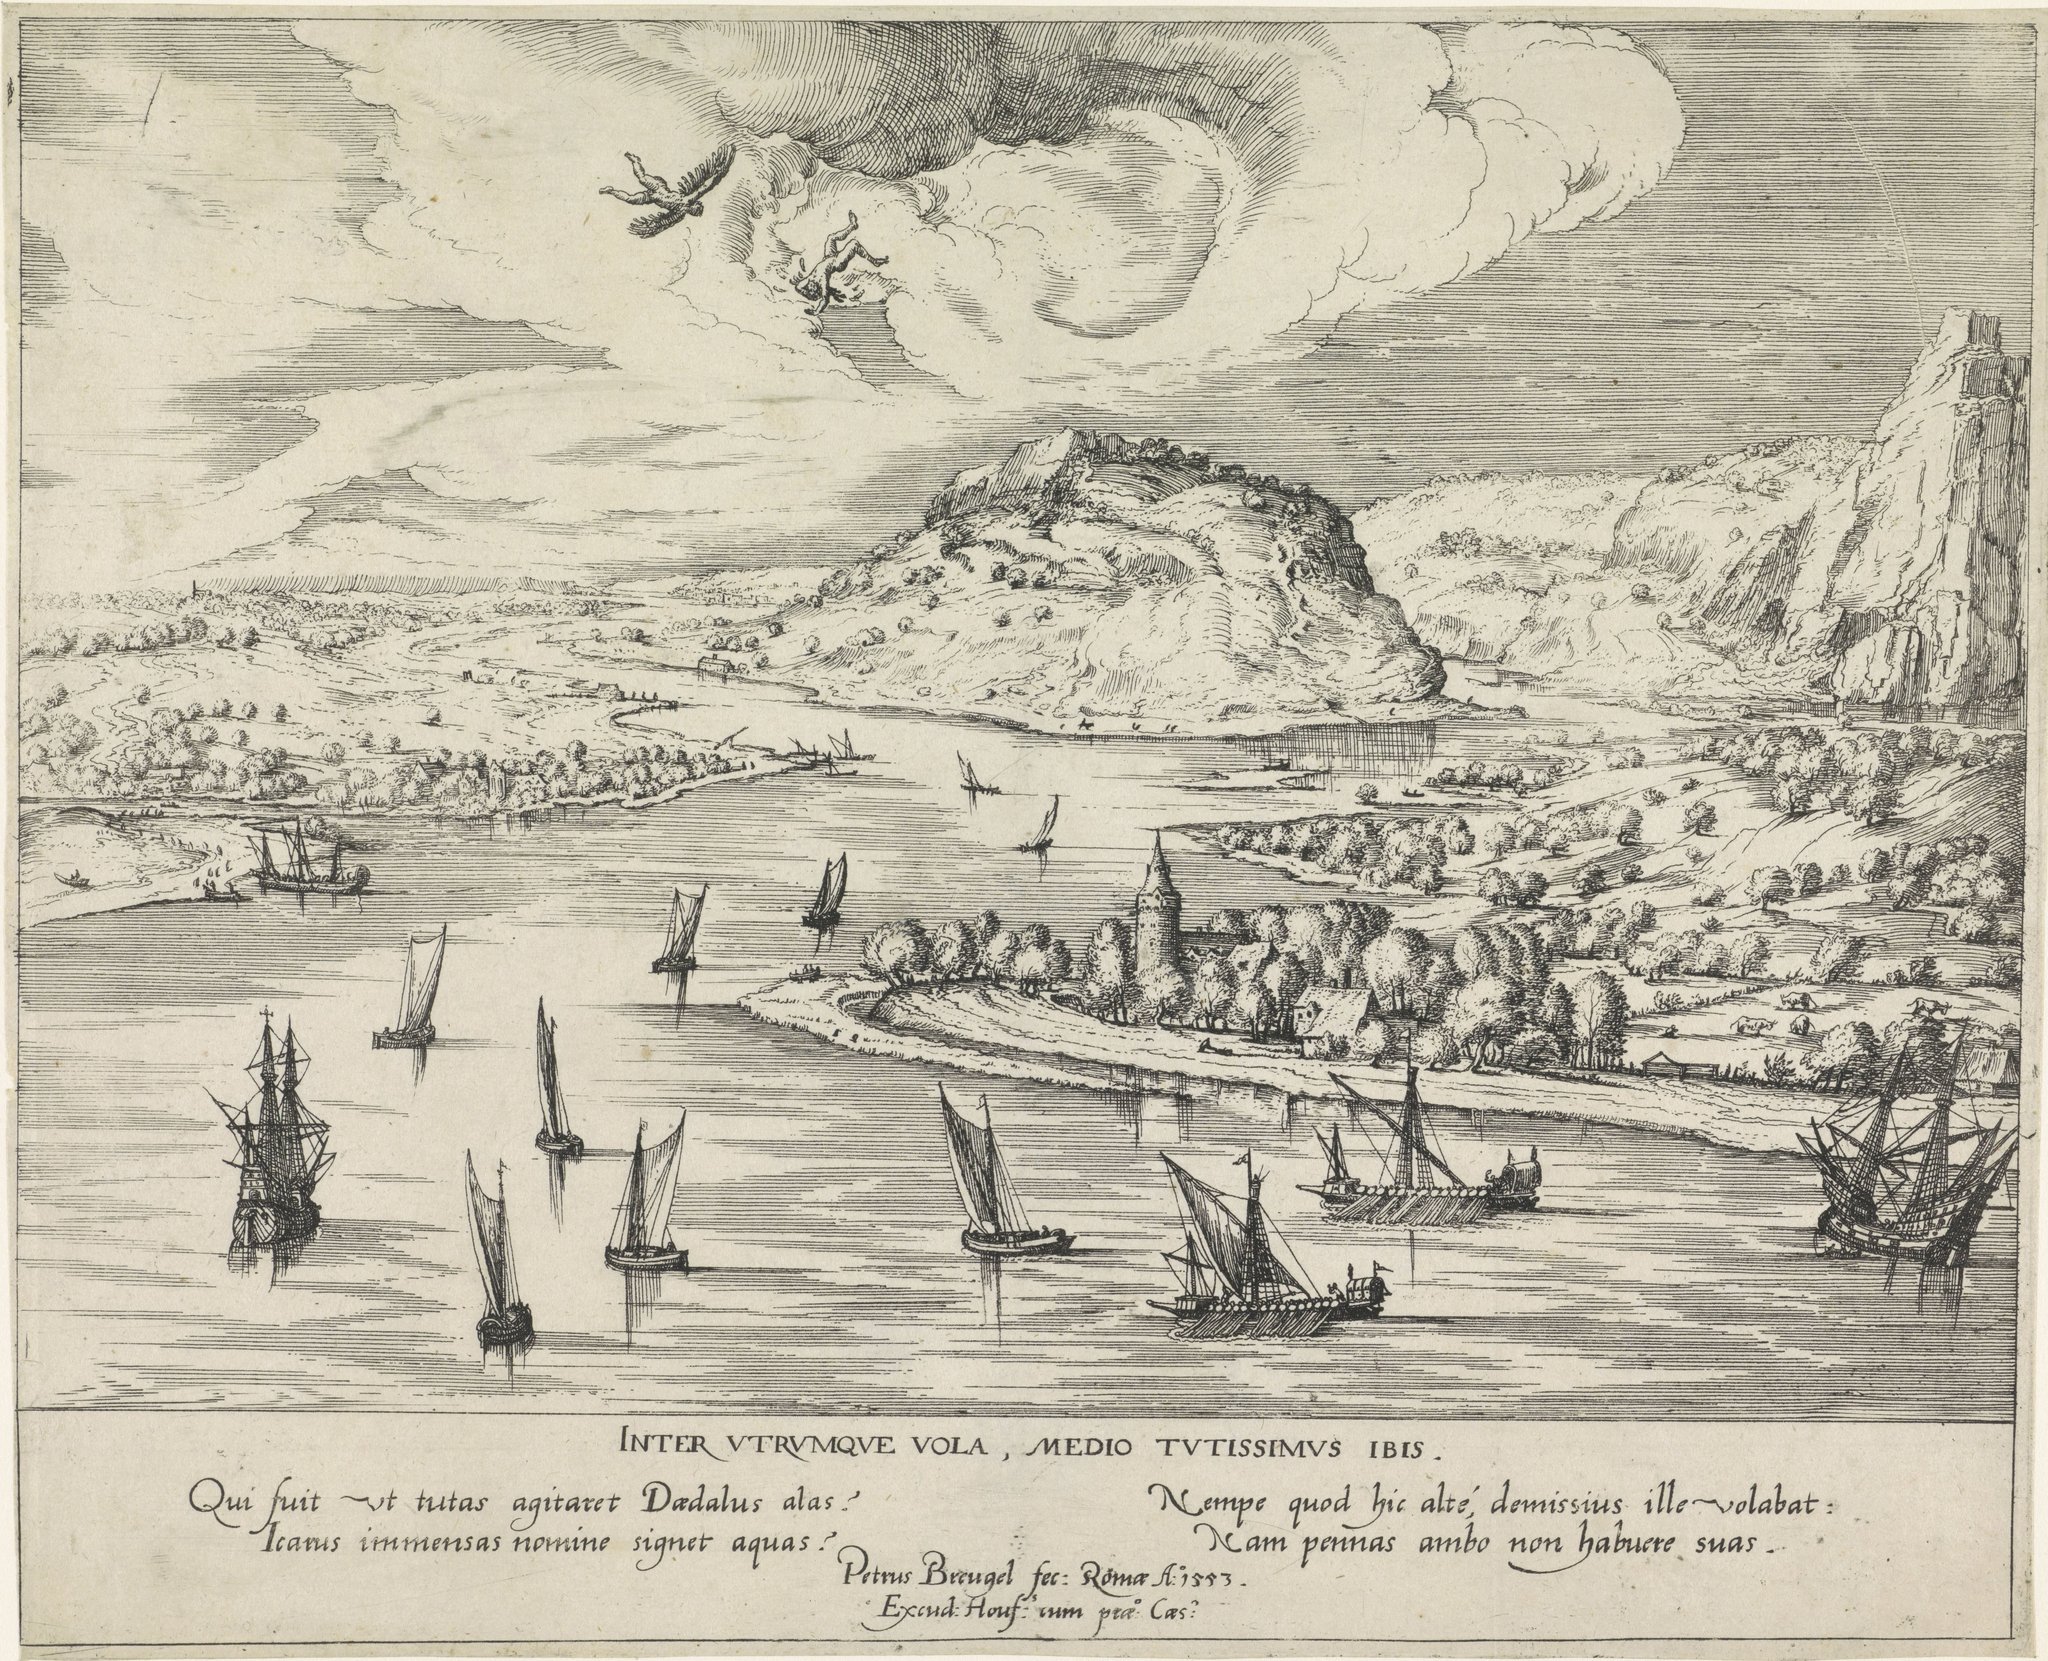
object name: print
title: Inter utrumque vola, medio tutissimus ibis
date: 1553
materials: paper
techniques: etching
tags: river, death i.e. the fall of icarus (daedalus present)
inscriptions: collector's mark: Lugt 2228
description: Rivierlandschap met zeilschepen op het water. In de lucht ziet de gevleugelde Daedalus zijn zoon Icarus naar beneden vallen.